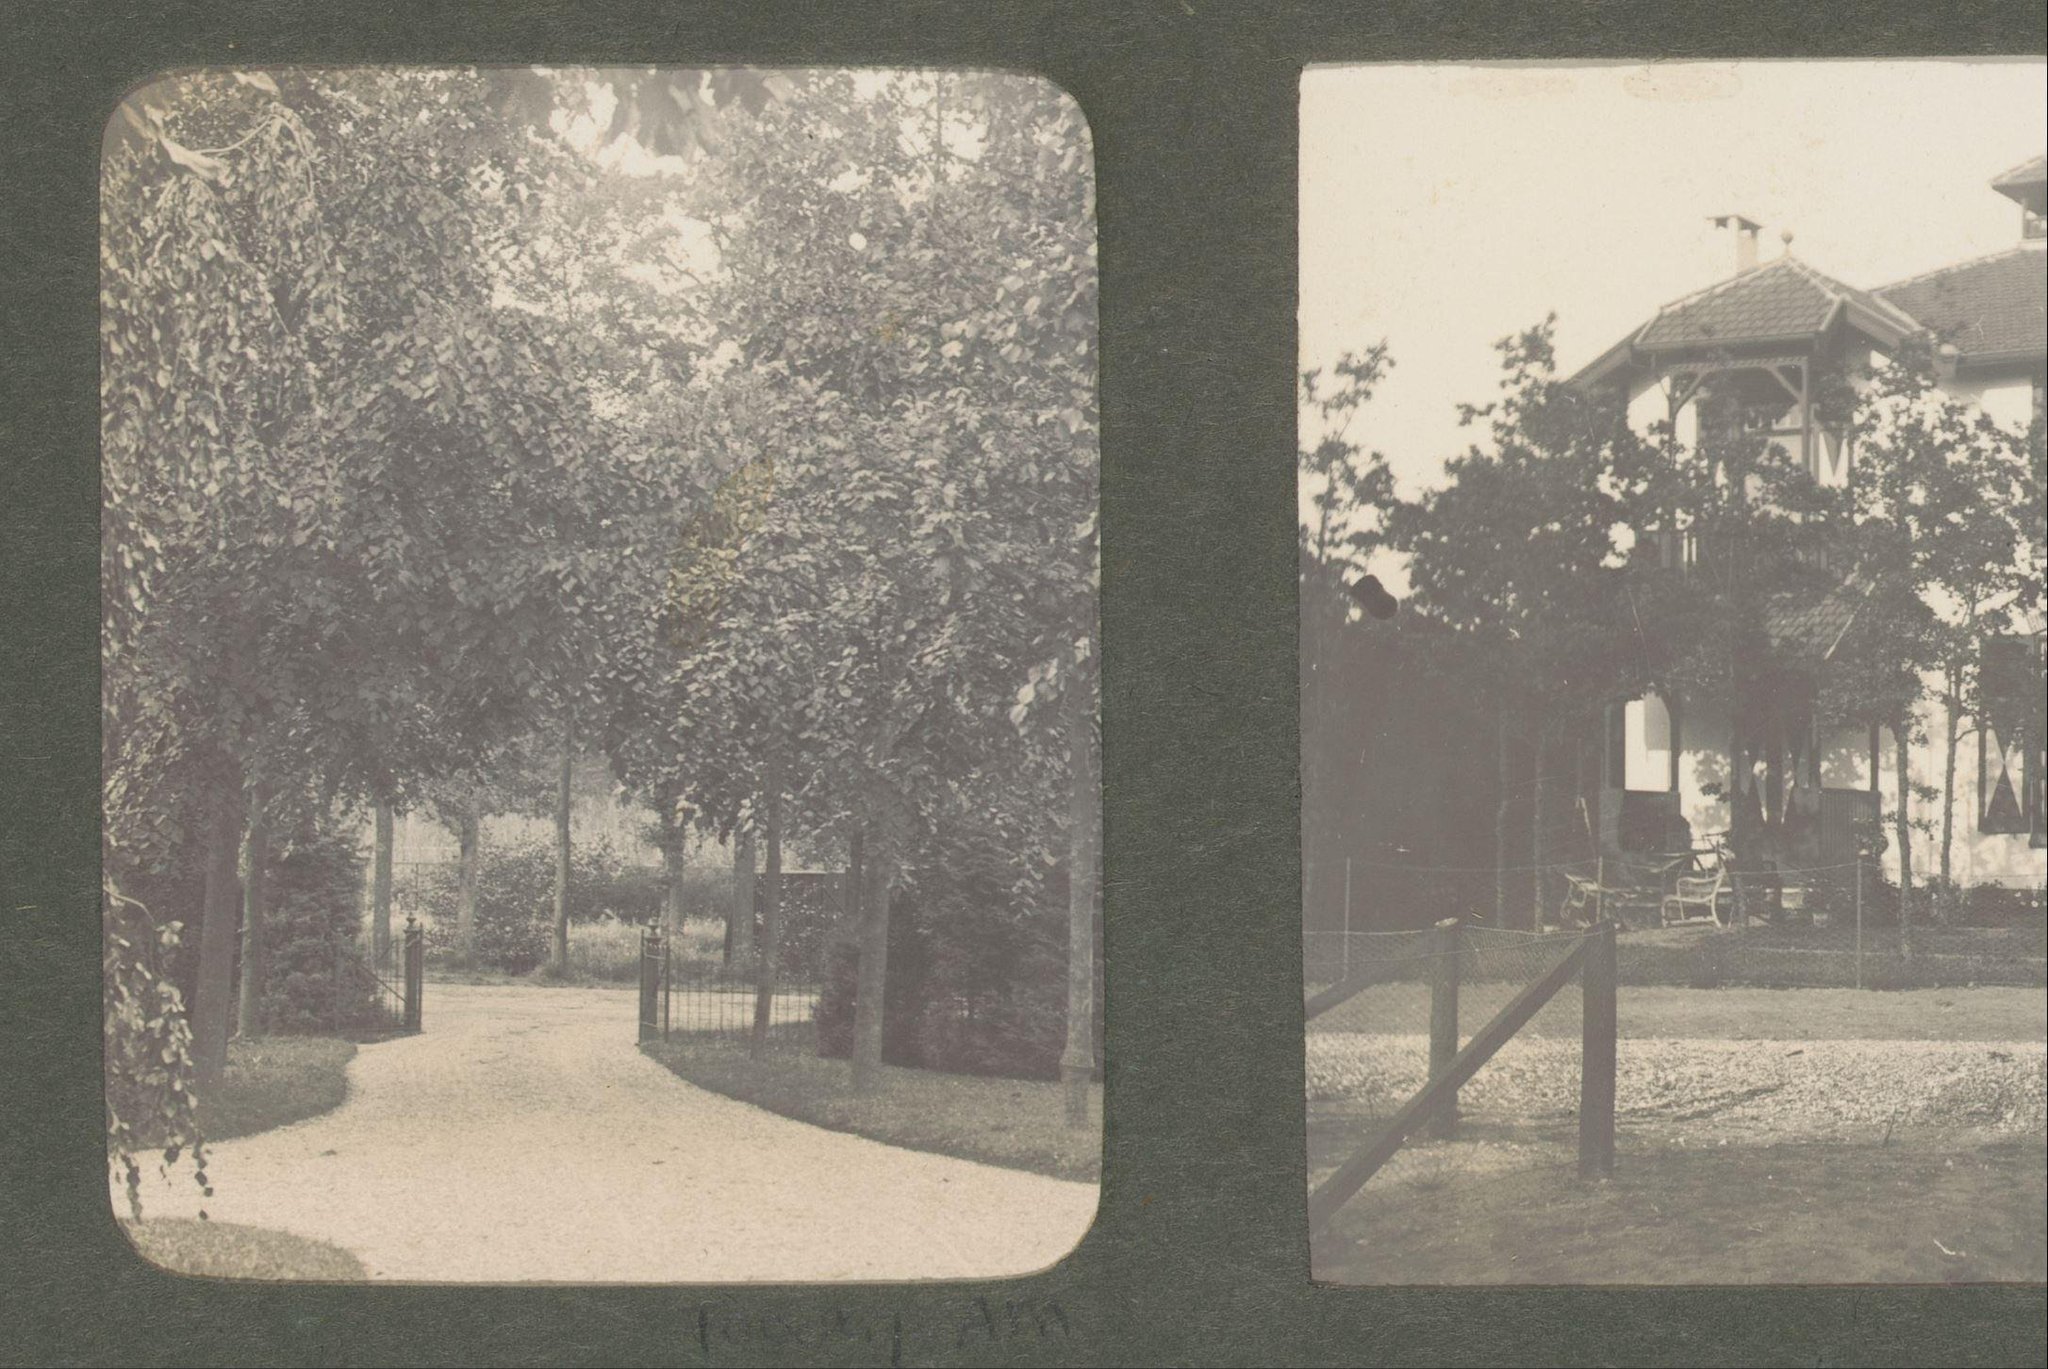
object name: album leaf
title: Toegangshek met oprijlaan, vermoedelijk in Nederland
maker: Anonymous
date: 1902-1906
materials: cardboard, paper, photographic support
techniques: gelatin silver print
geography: netherlands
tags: gate, entrance, netherlands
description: Onderdeel van Reisalbum van een Nederlandse familie met bezienswaardigheden in Europa, Egypte en New York.